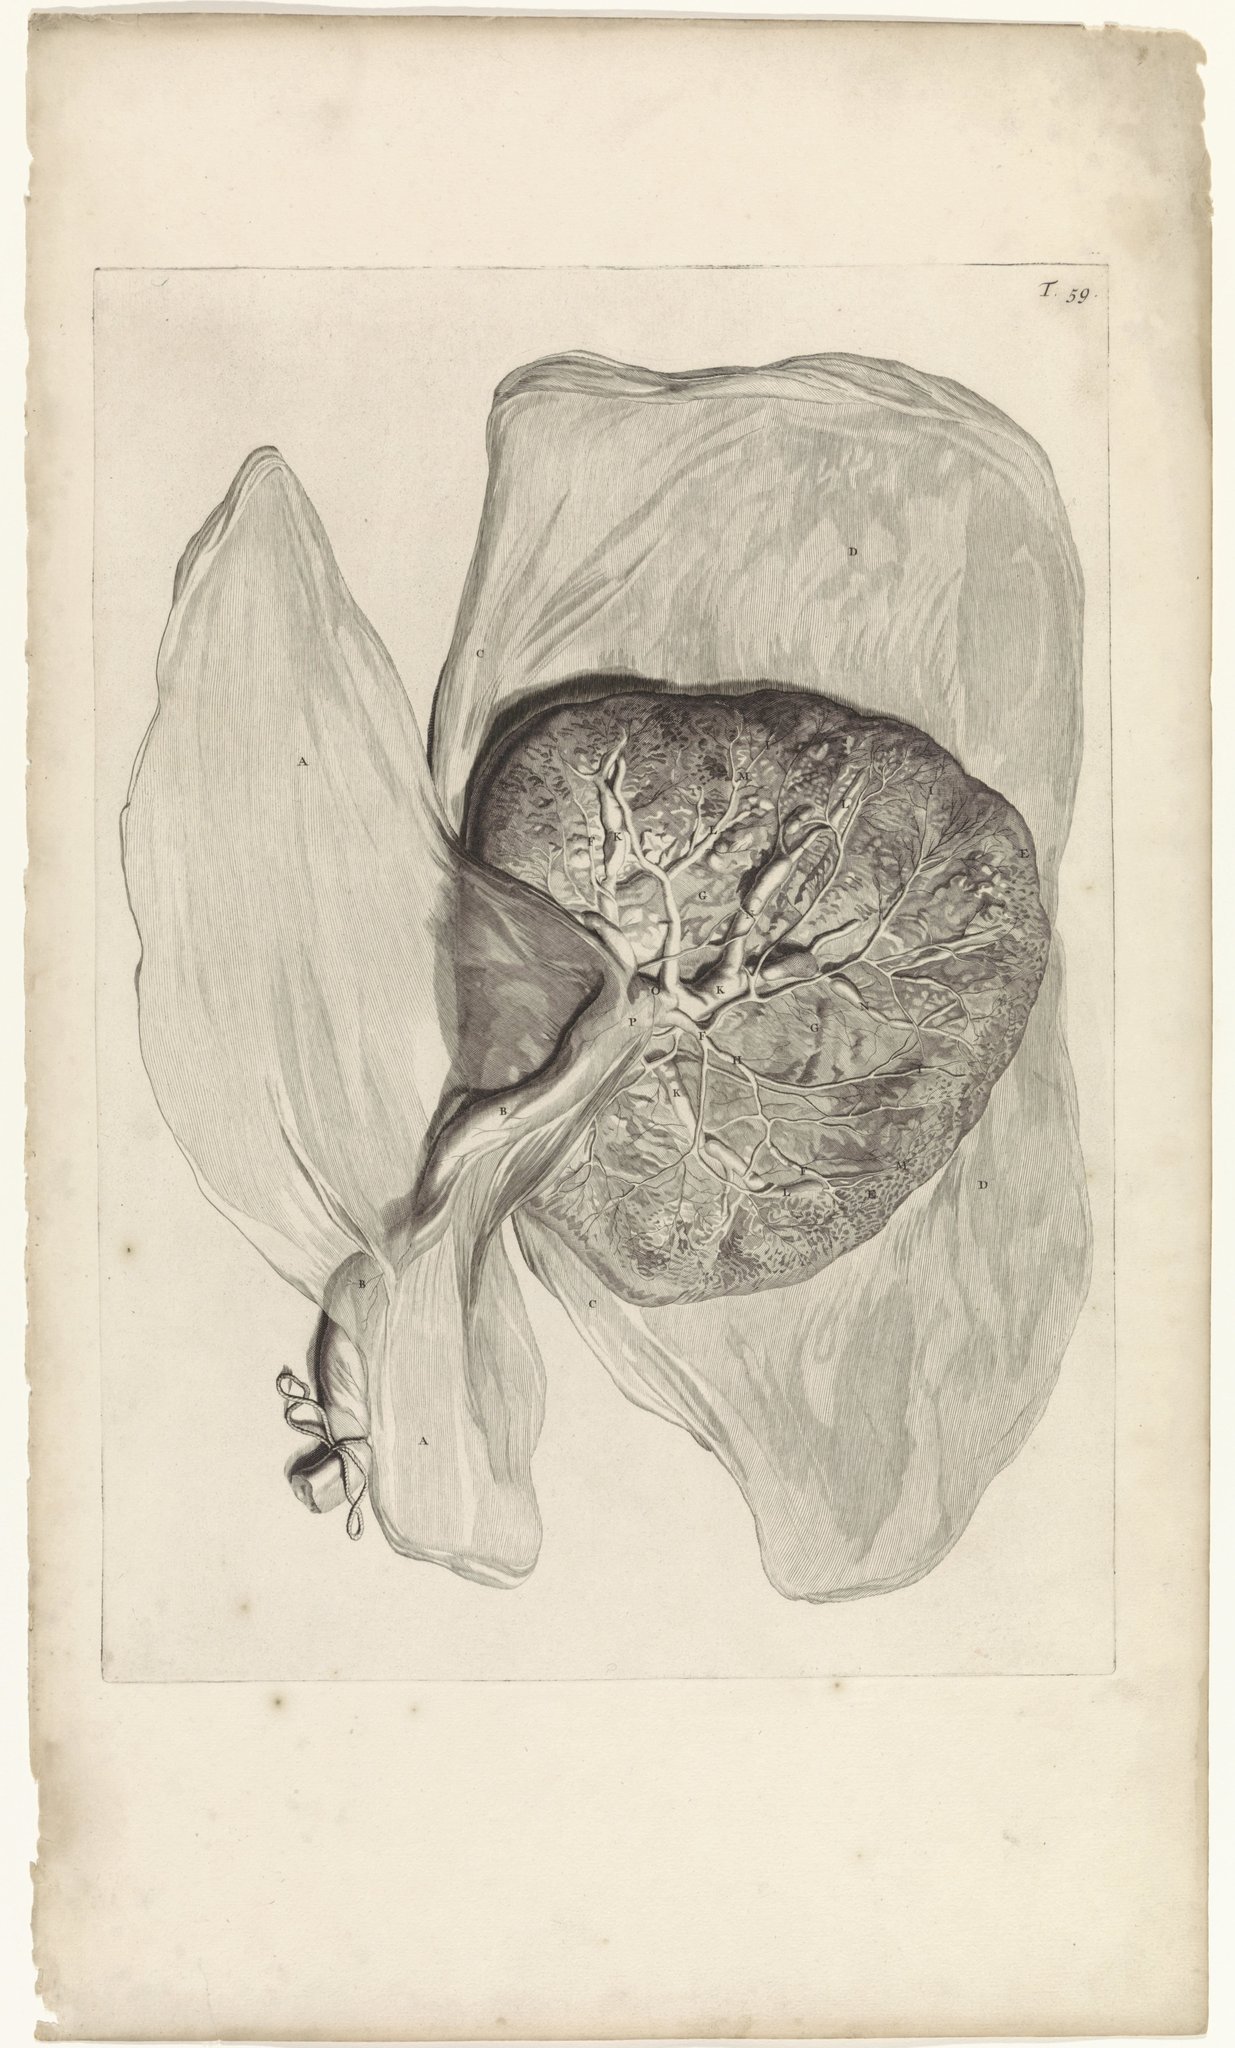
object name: book illustration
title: Anatomische studie van de onderkant van de placenta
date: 1685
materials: paper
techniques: engraving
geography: amsterdam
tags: placenta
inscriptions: collector's mark: Lugt 2228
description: Boekillustratie voor Bidloo, Godefridus. Anatomia humani corporis centum & quinque tabulis, per art. G. de Lairesse ad vivum delineatis, de monstrata, veterum recentiorumque inventis explicata plurimisque, hactenus non detectis, illustrata. Amsterdam: Weduwe Joannes van Someren, Hendrick Boom en erven Dirk Boom, 1685.